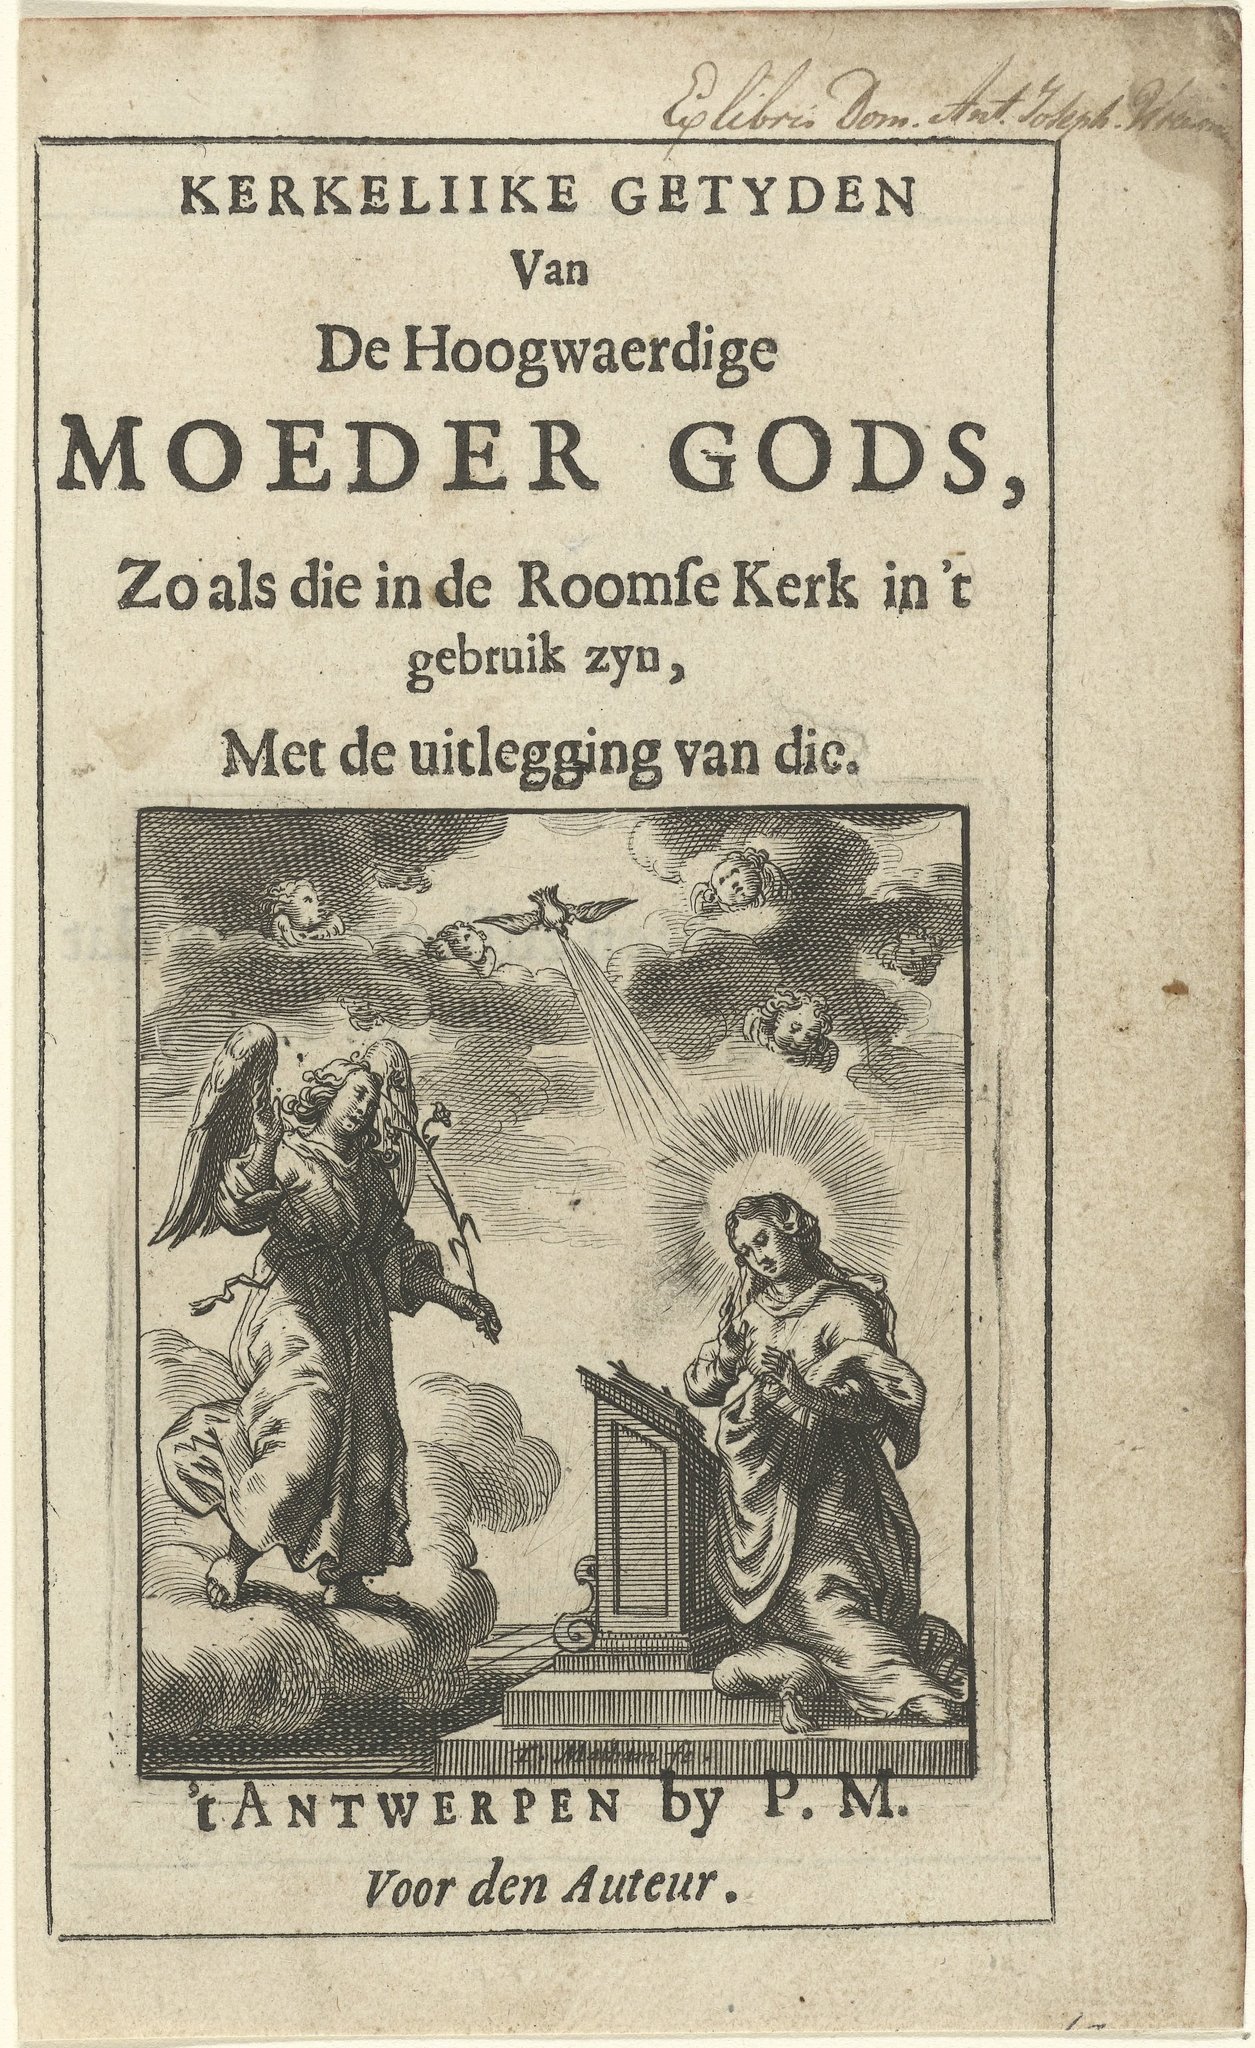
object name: print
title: Annunciatie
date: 1651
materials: paper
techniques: engraving, letterpress printing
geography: antwerp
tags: the annunciation: mary kneeling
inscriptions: collector's mark: Lugt 2228, inscription: ‘Exlibris Dom. Ant. Joseph W[...]’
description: Titelpagina voor: Marius, Leonardus. Kerkeliike getyden van de hoogwaerdige moeder Gods, zoals die in de Roomse kerk in't gebruik zyn. Antwerpen: Philippus Michielsen, 1651.